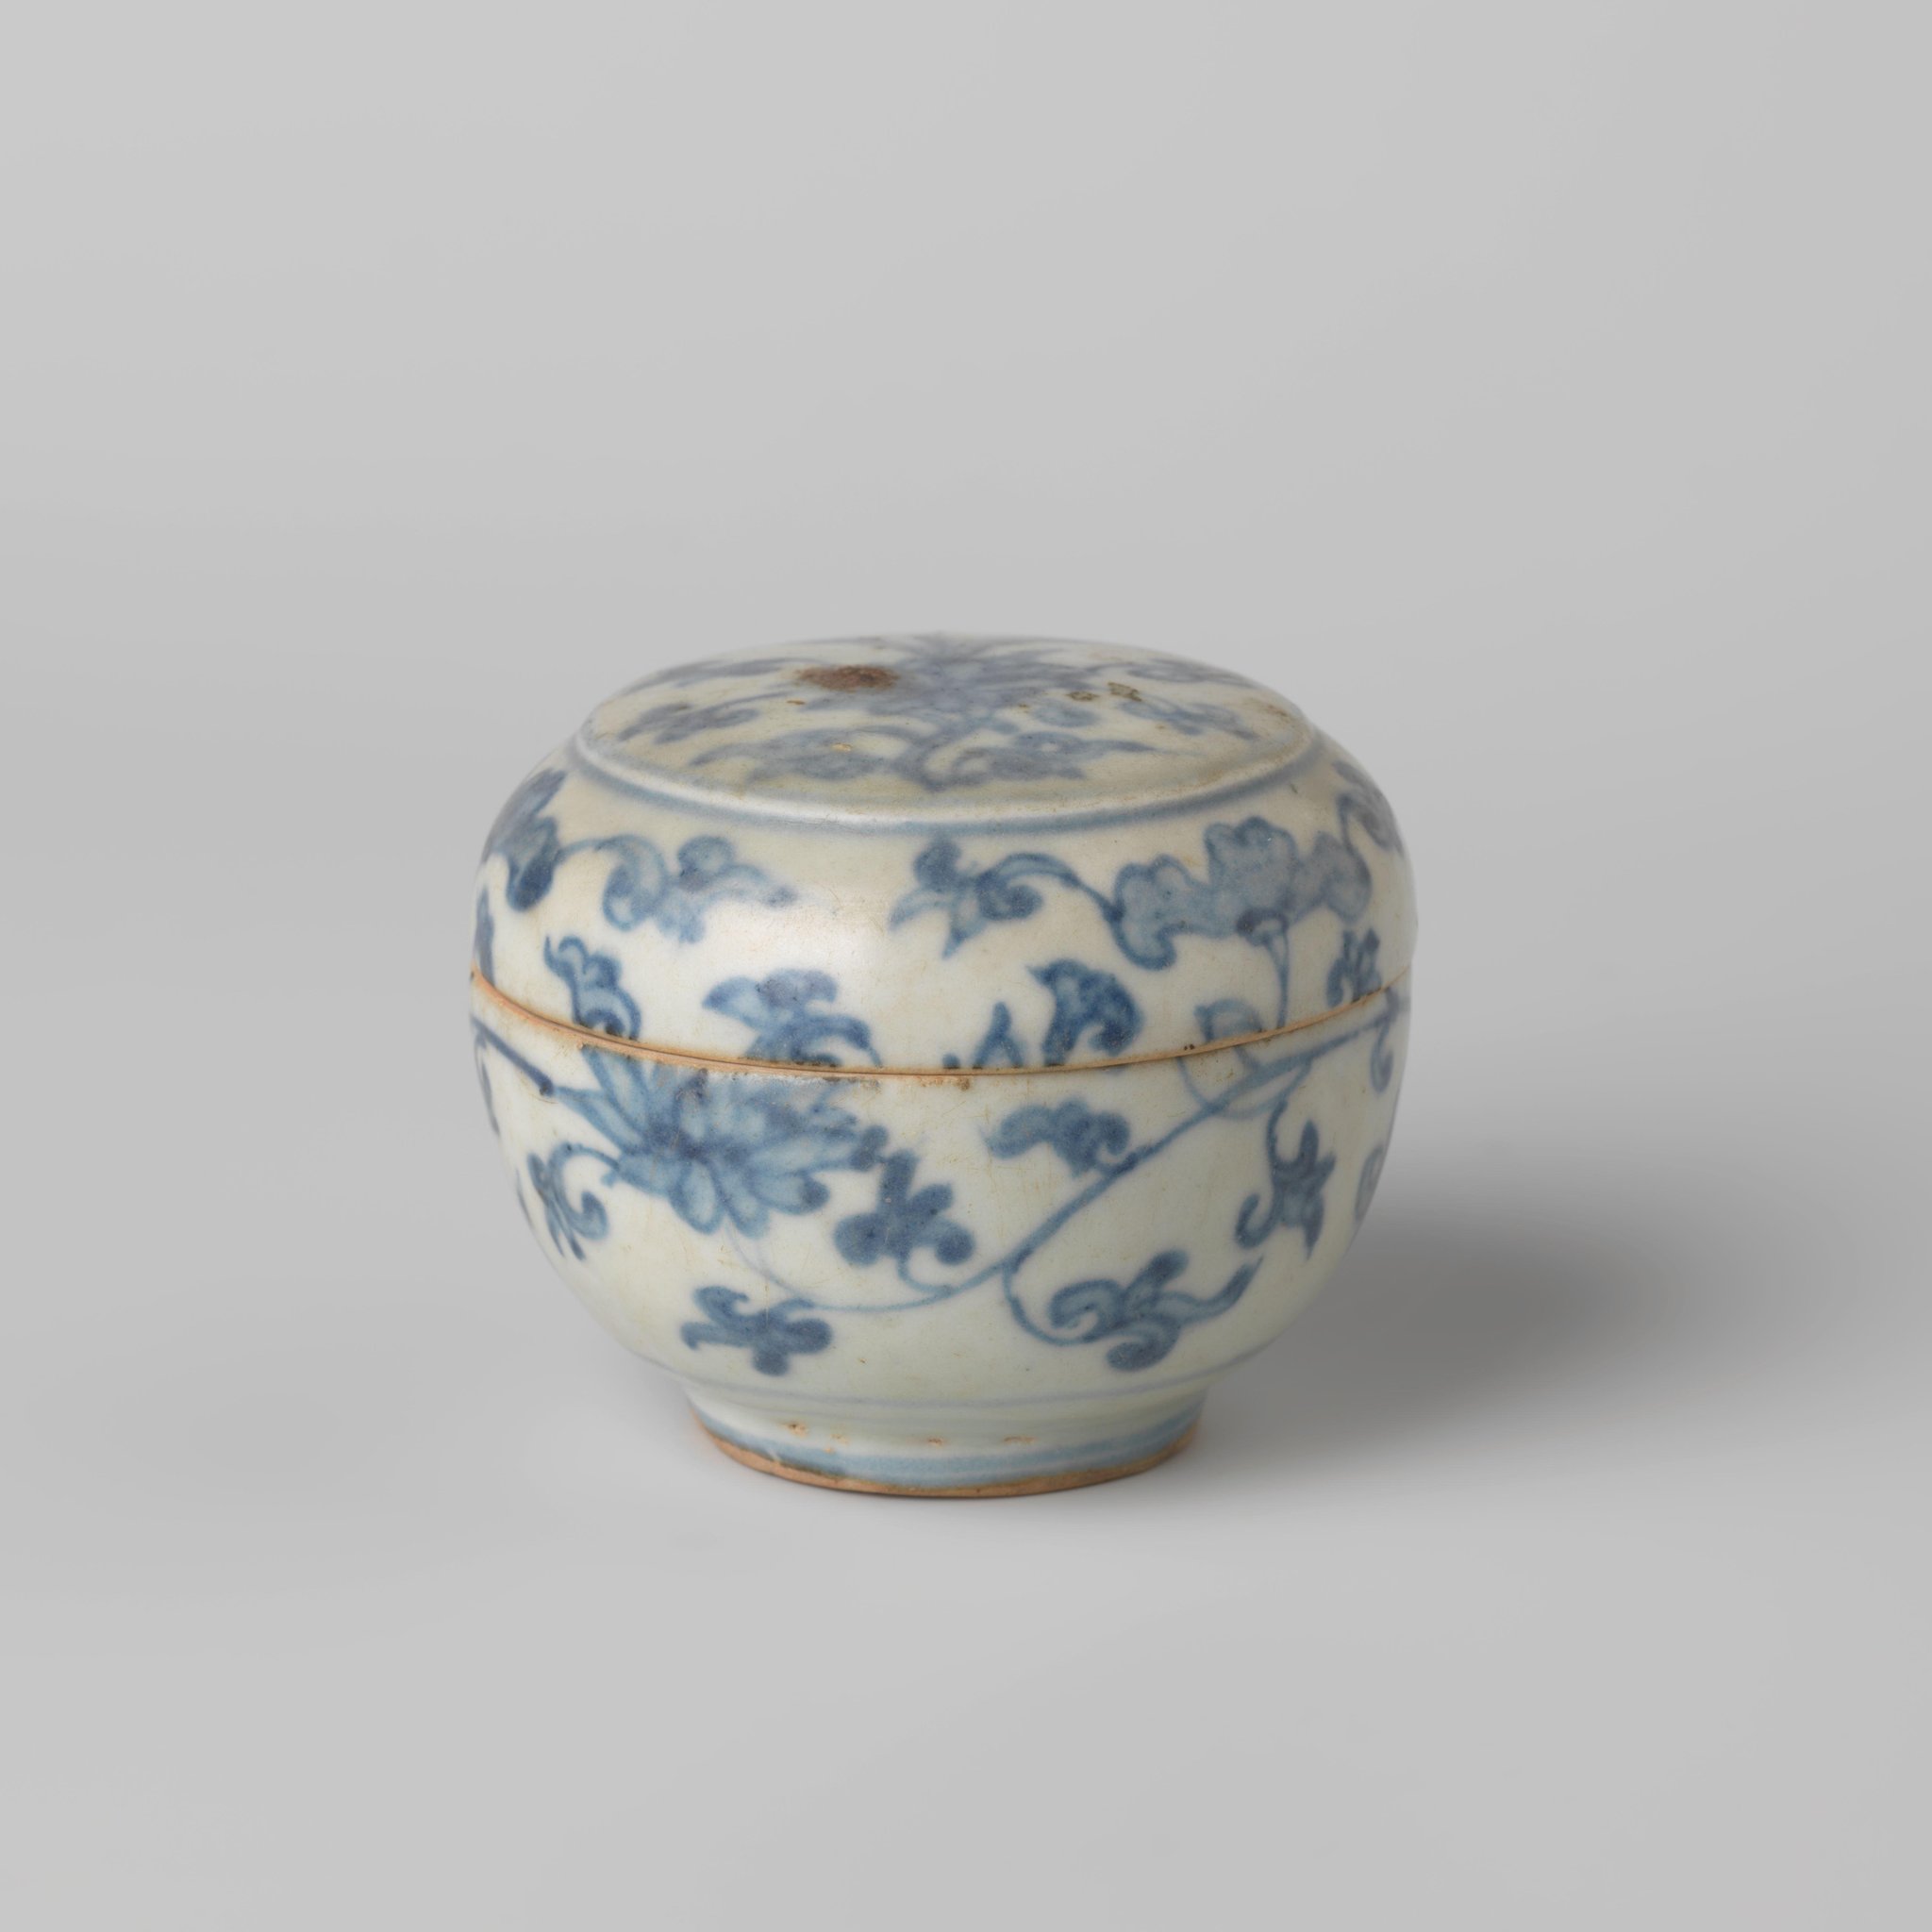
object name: box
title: Round box with lotus scrolls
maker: Anonymous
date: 1500-1599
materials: cobalt, glaze, paint, porcelain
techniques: firing, turning, vitrification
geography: china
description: Deksel van ronde dekseldoos van porselein, beschilderd in onderglazuur blauw. Op de zijkant van de deksel doorlopende lotusranken. Op de bovenzijde van de deksel een verhoogd medaillon met daarin een lotustak. Blauw-wit.